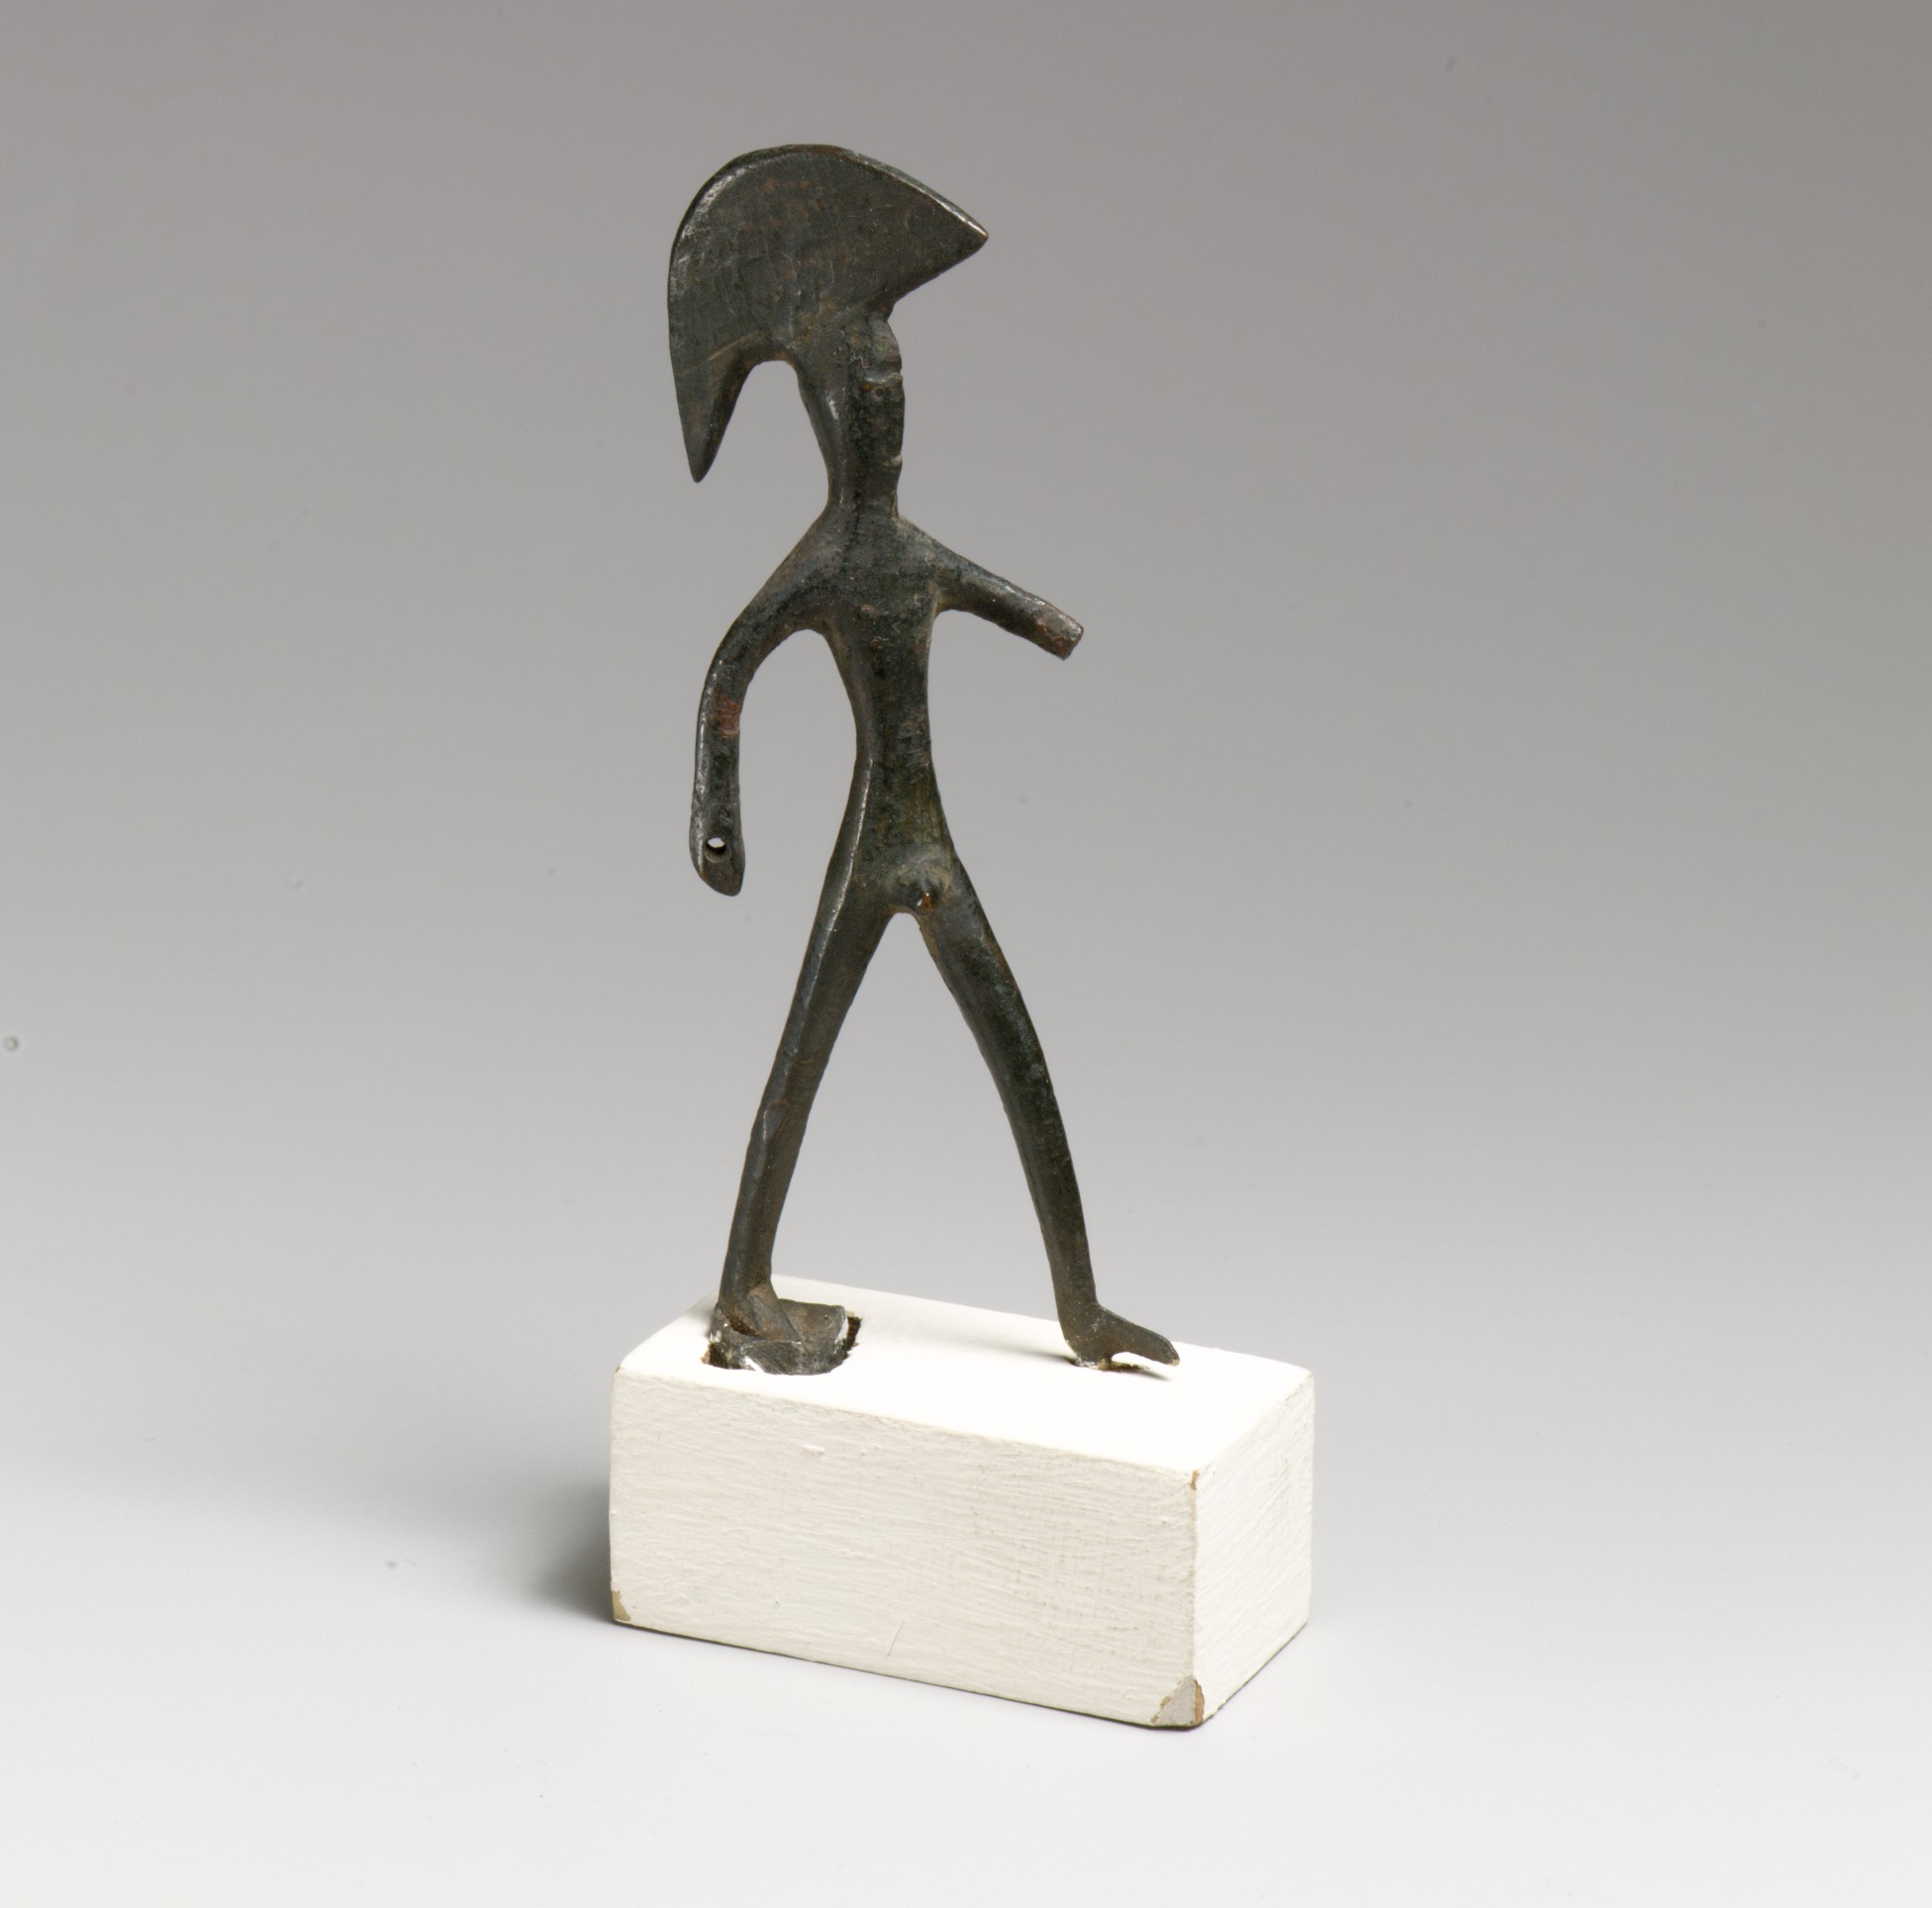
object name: statuette of a warrior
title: Statuette of striding warrior (Ares?)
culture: etruscan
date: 600-501 BCE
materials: bronze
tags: men,warriors